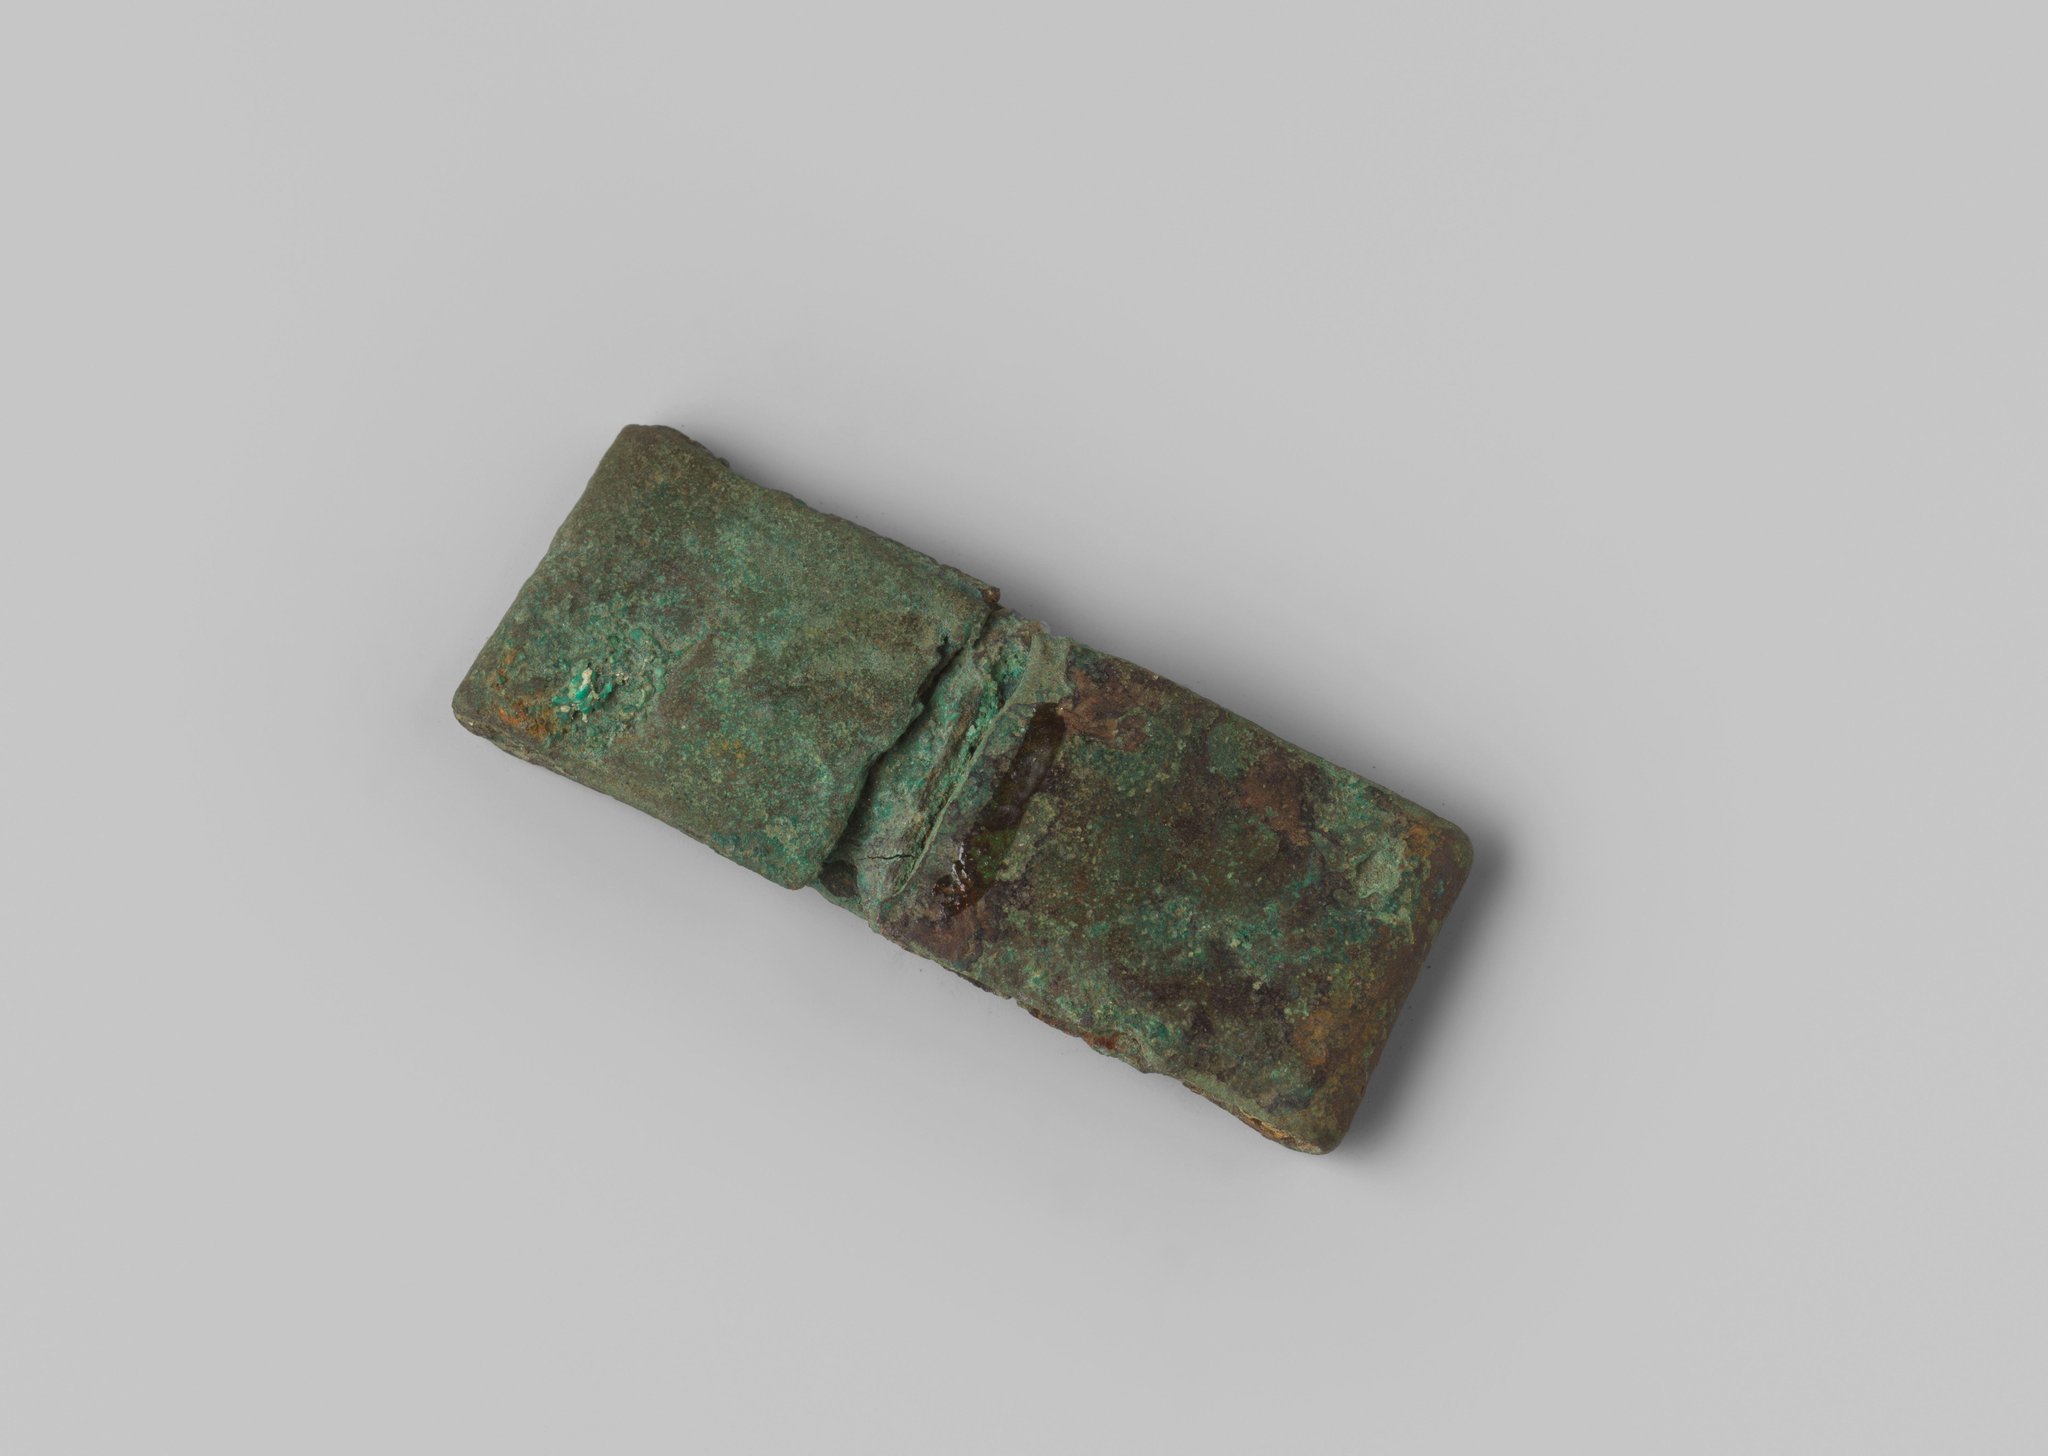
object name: firehose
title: Brandslangring uit het wrak van de Oost-Indiëvaarder Hollandia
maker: Anonymous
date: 1700-1743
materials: copper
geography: netherlands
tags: verenigde oostindische compagnie, hollandia (schip), annet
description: Firehose, fragm, id. NG 1975-20H1271a, squashed.